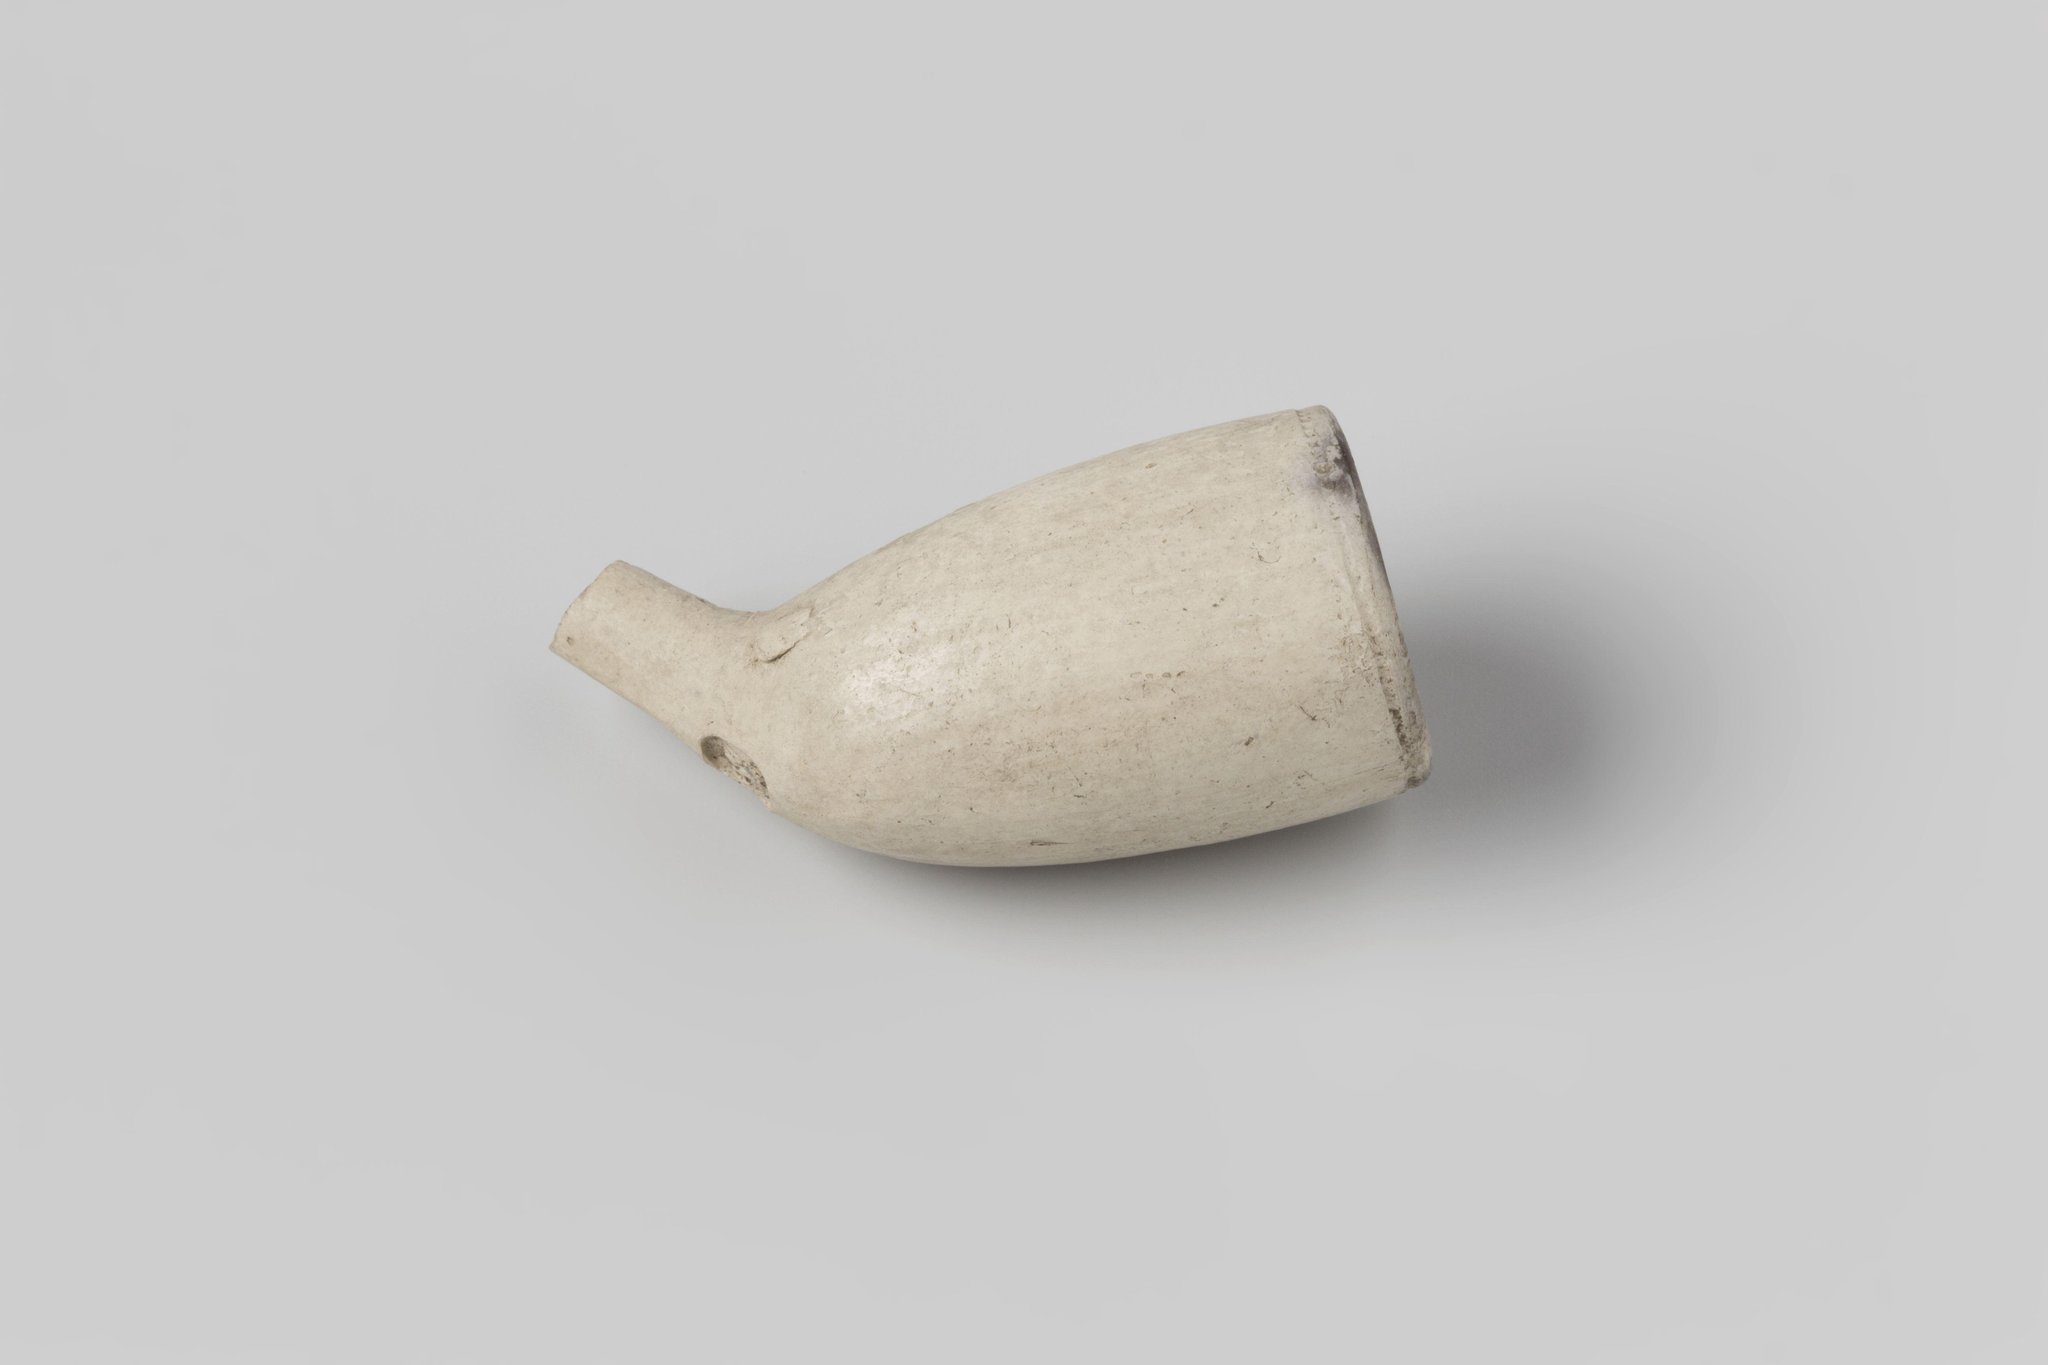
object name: pipe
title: Fragment tabakspijp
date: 1750-1780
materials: clay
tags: the hague, rotterdam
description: Fragment tabakspijp, rondbodem model. Van de opgravingen op de Hofstede Arentsburg 1827-1831 onder toezicht van Professor Reuvens.